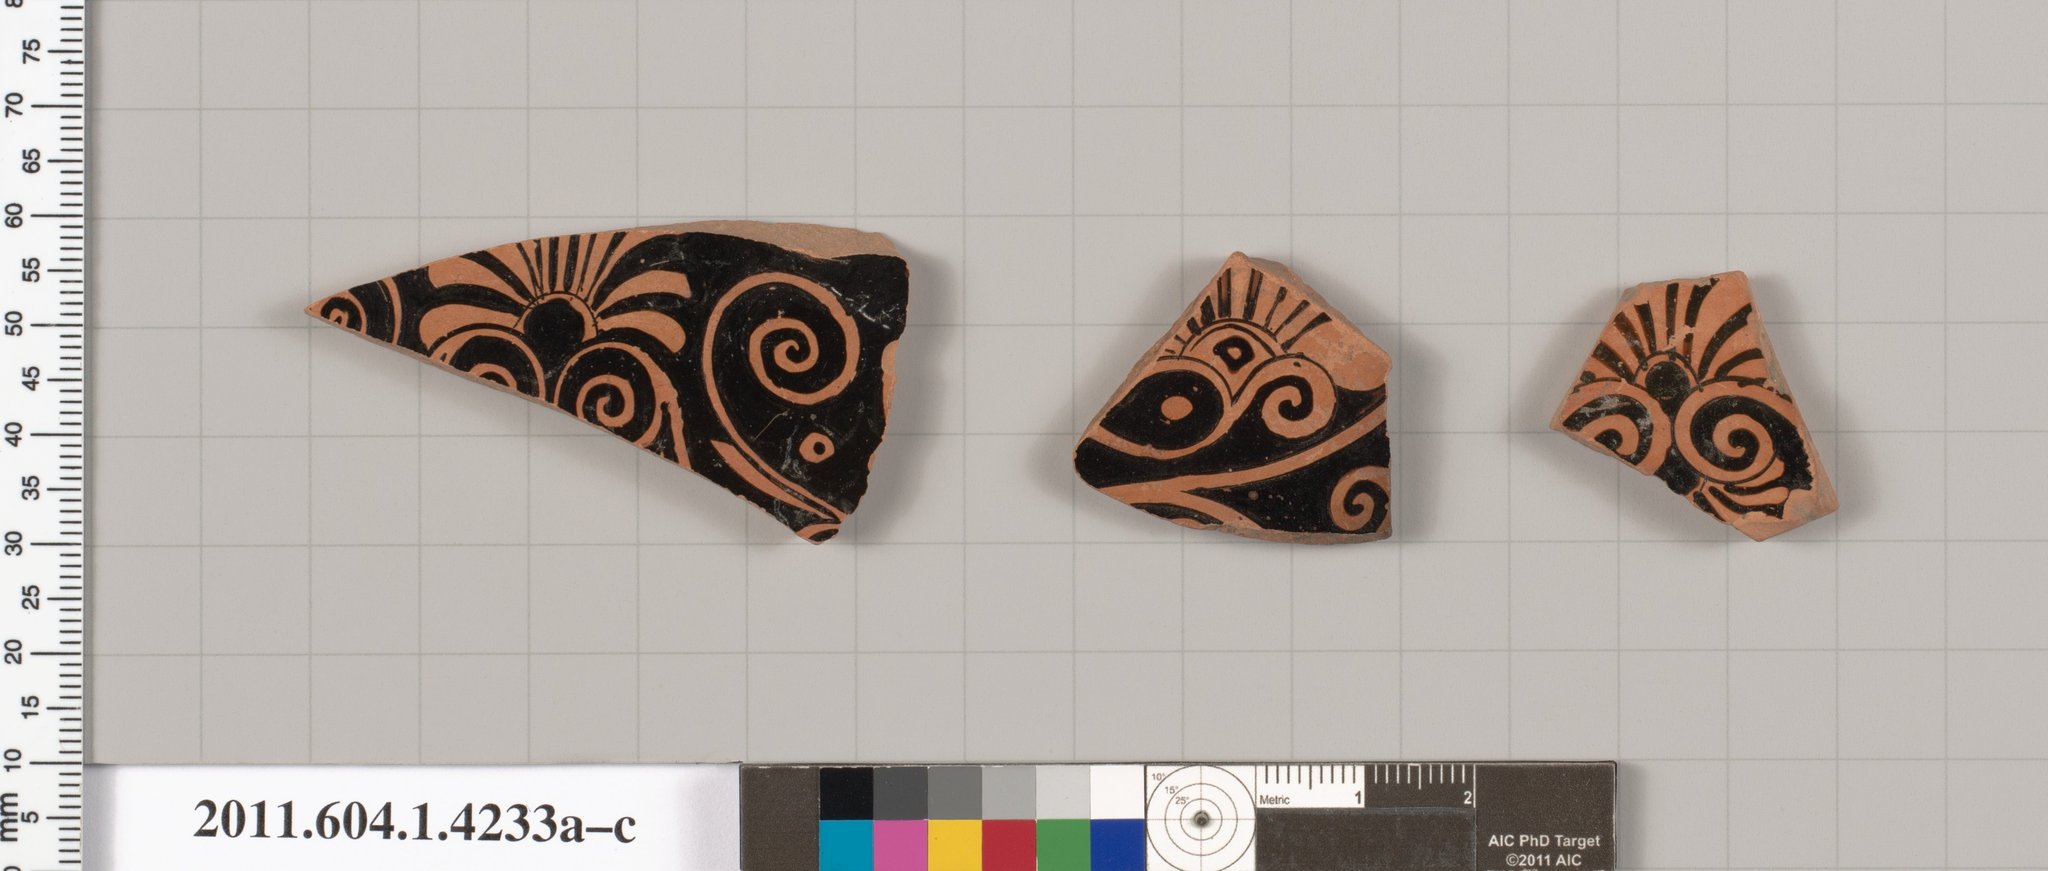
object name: kylix fragment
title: Terracotta fragments of kylikes (drinking cups)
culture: greek, attic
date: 500-476 BCE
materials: terracotta